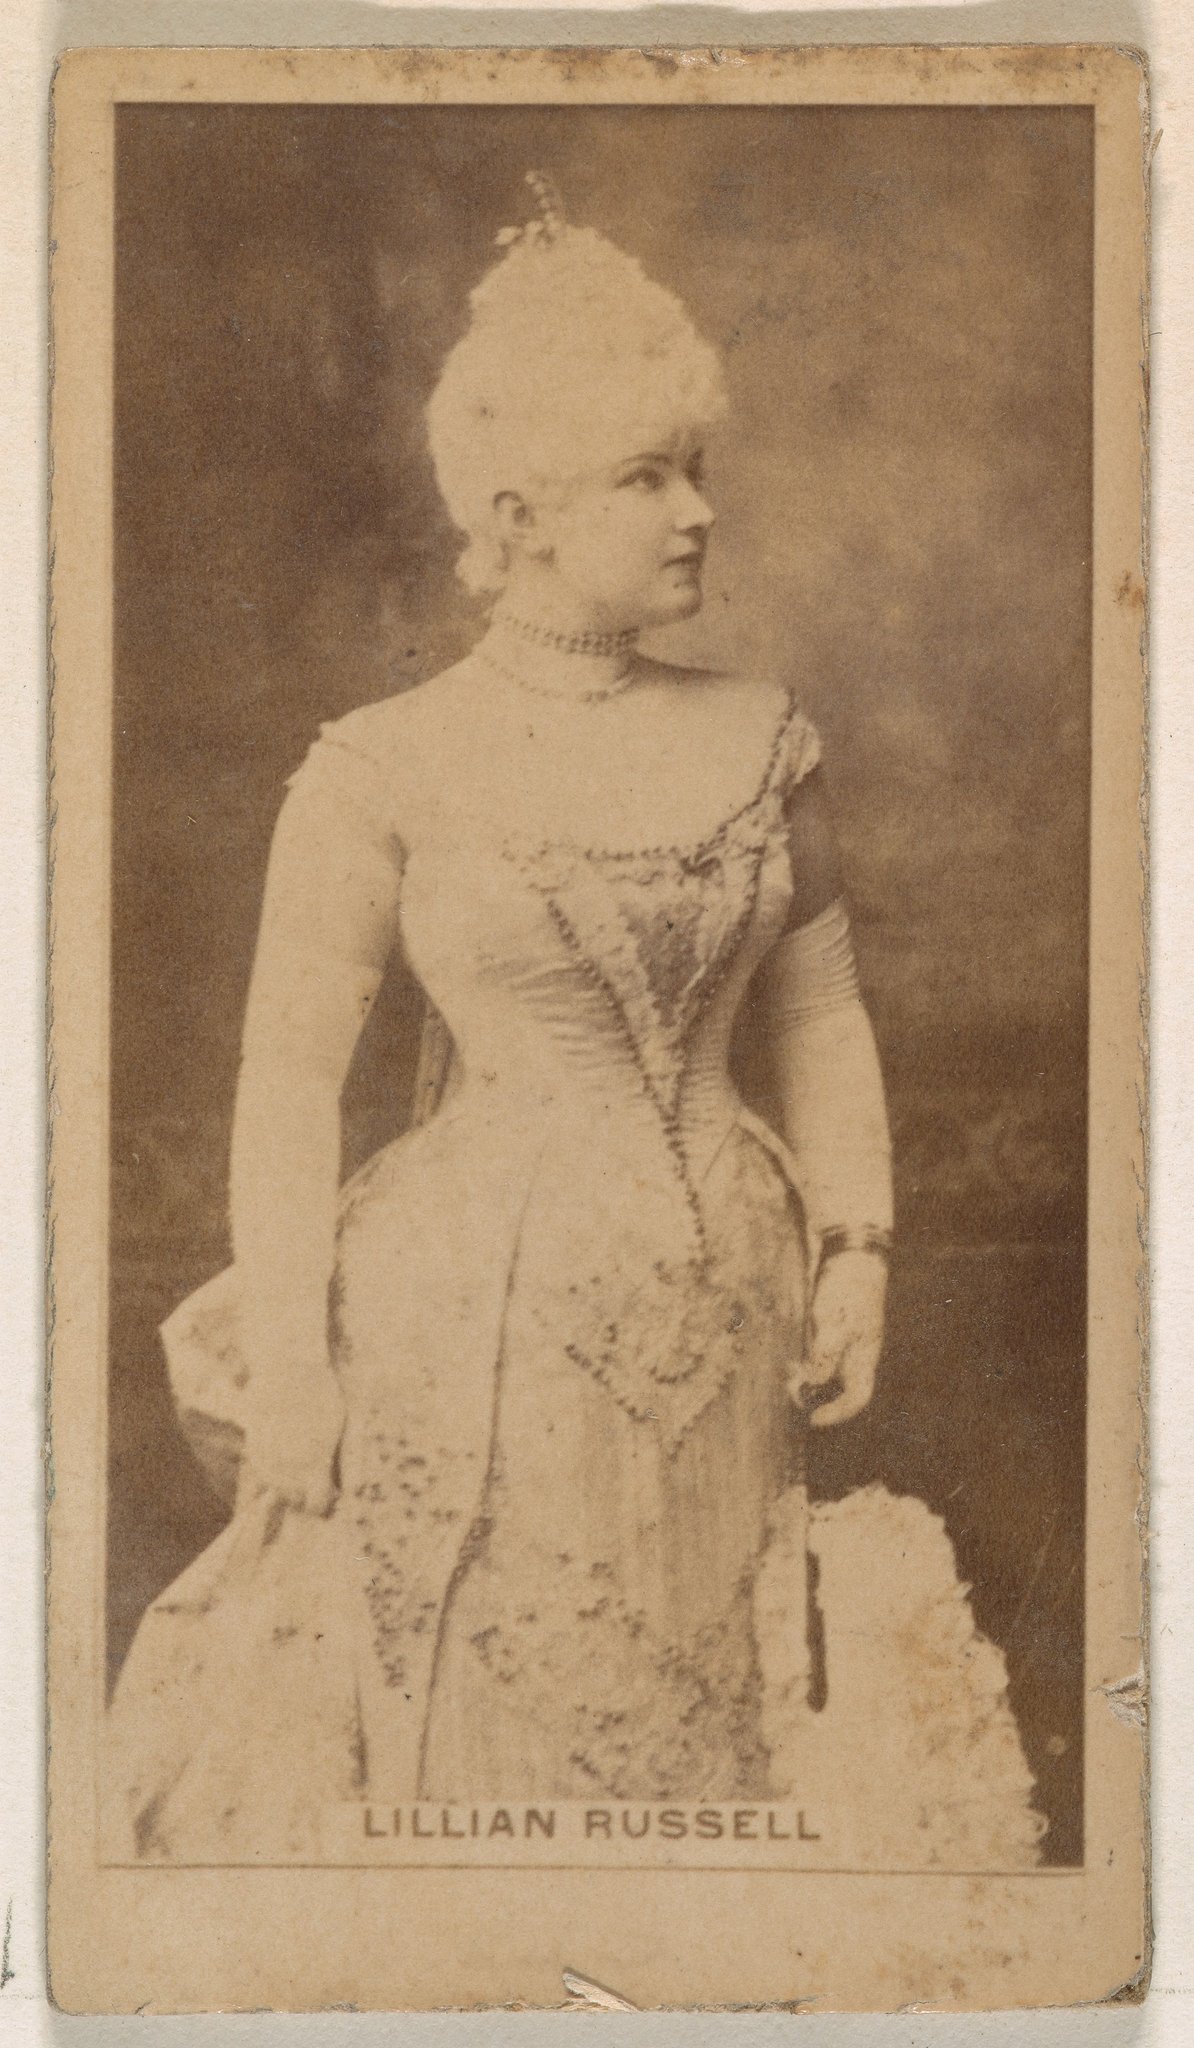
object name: photograph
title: Lillian Russell, from the Actresses series (N245) issued by Kinney Brothers to promote Sweet Caporal Cigarettes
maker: kinney brothers tobacco company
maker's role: publisher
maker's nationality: american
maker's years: 1869-2011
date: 1890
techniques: albumen silver print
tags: portraits,women,actresses